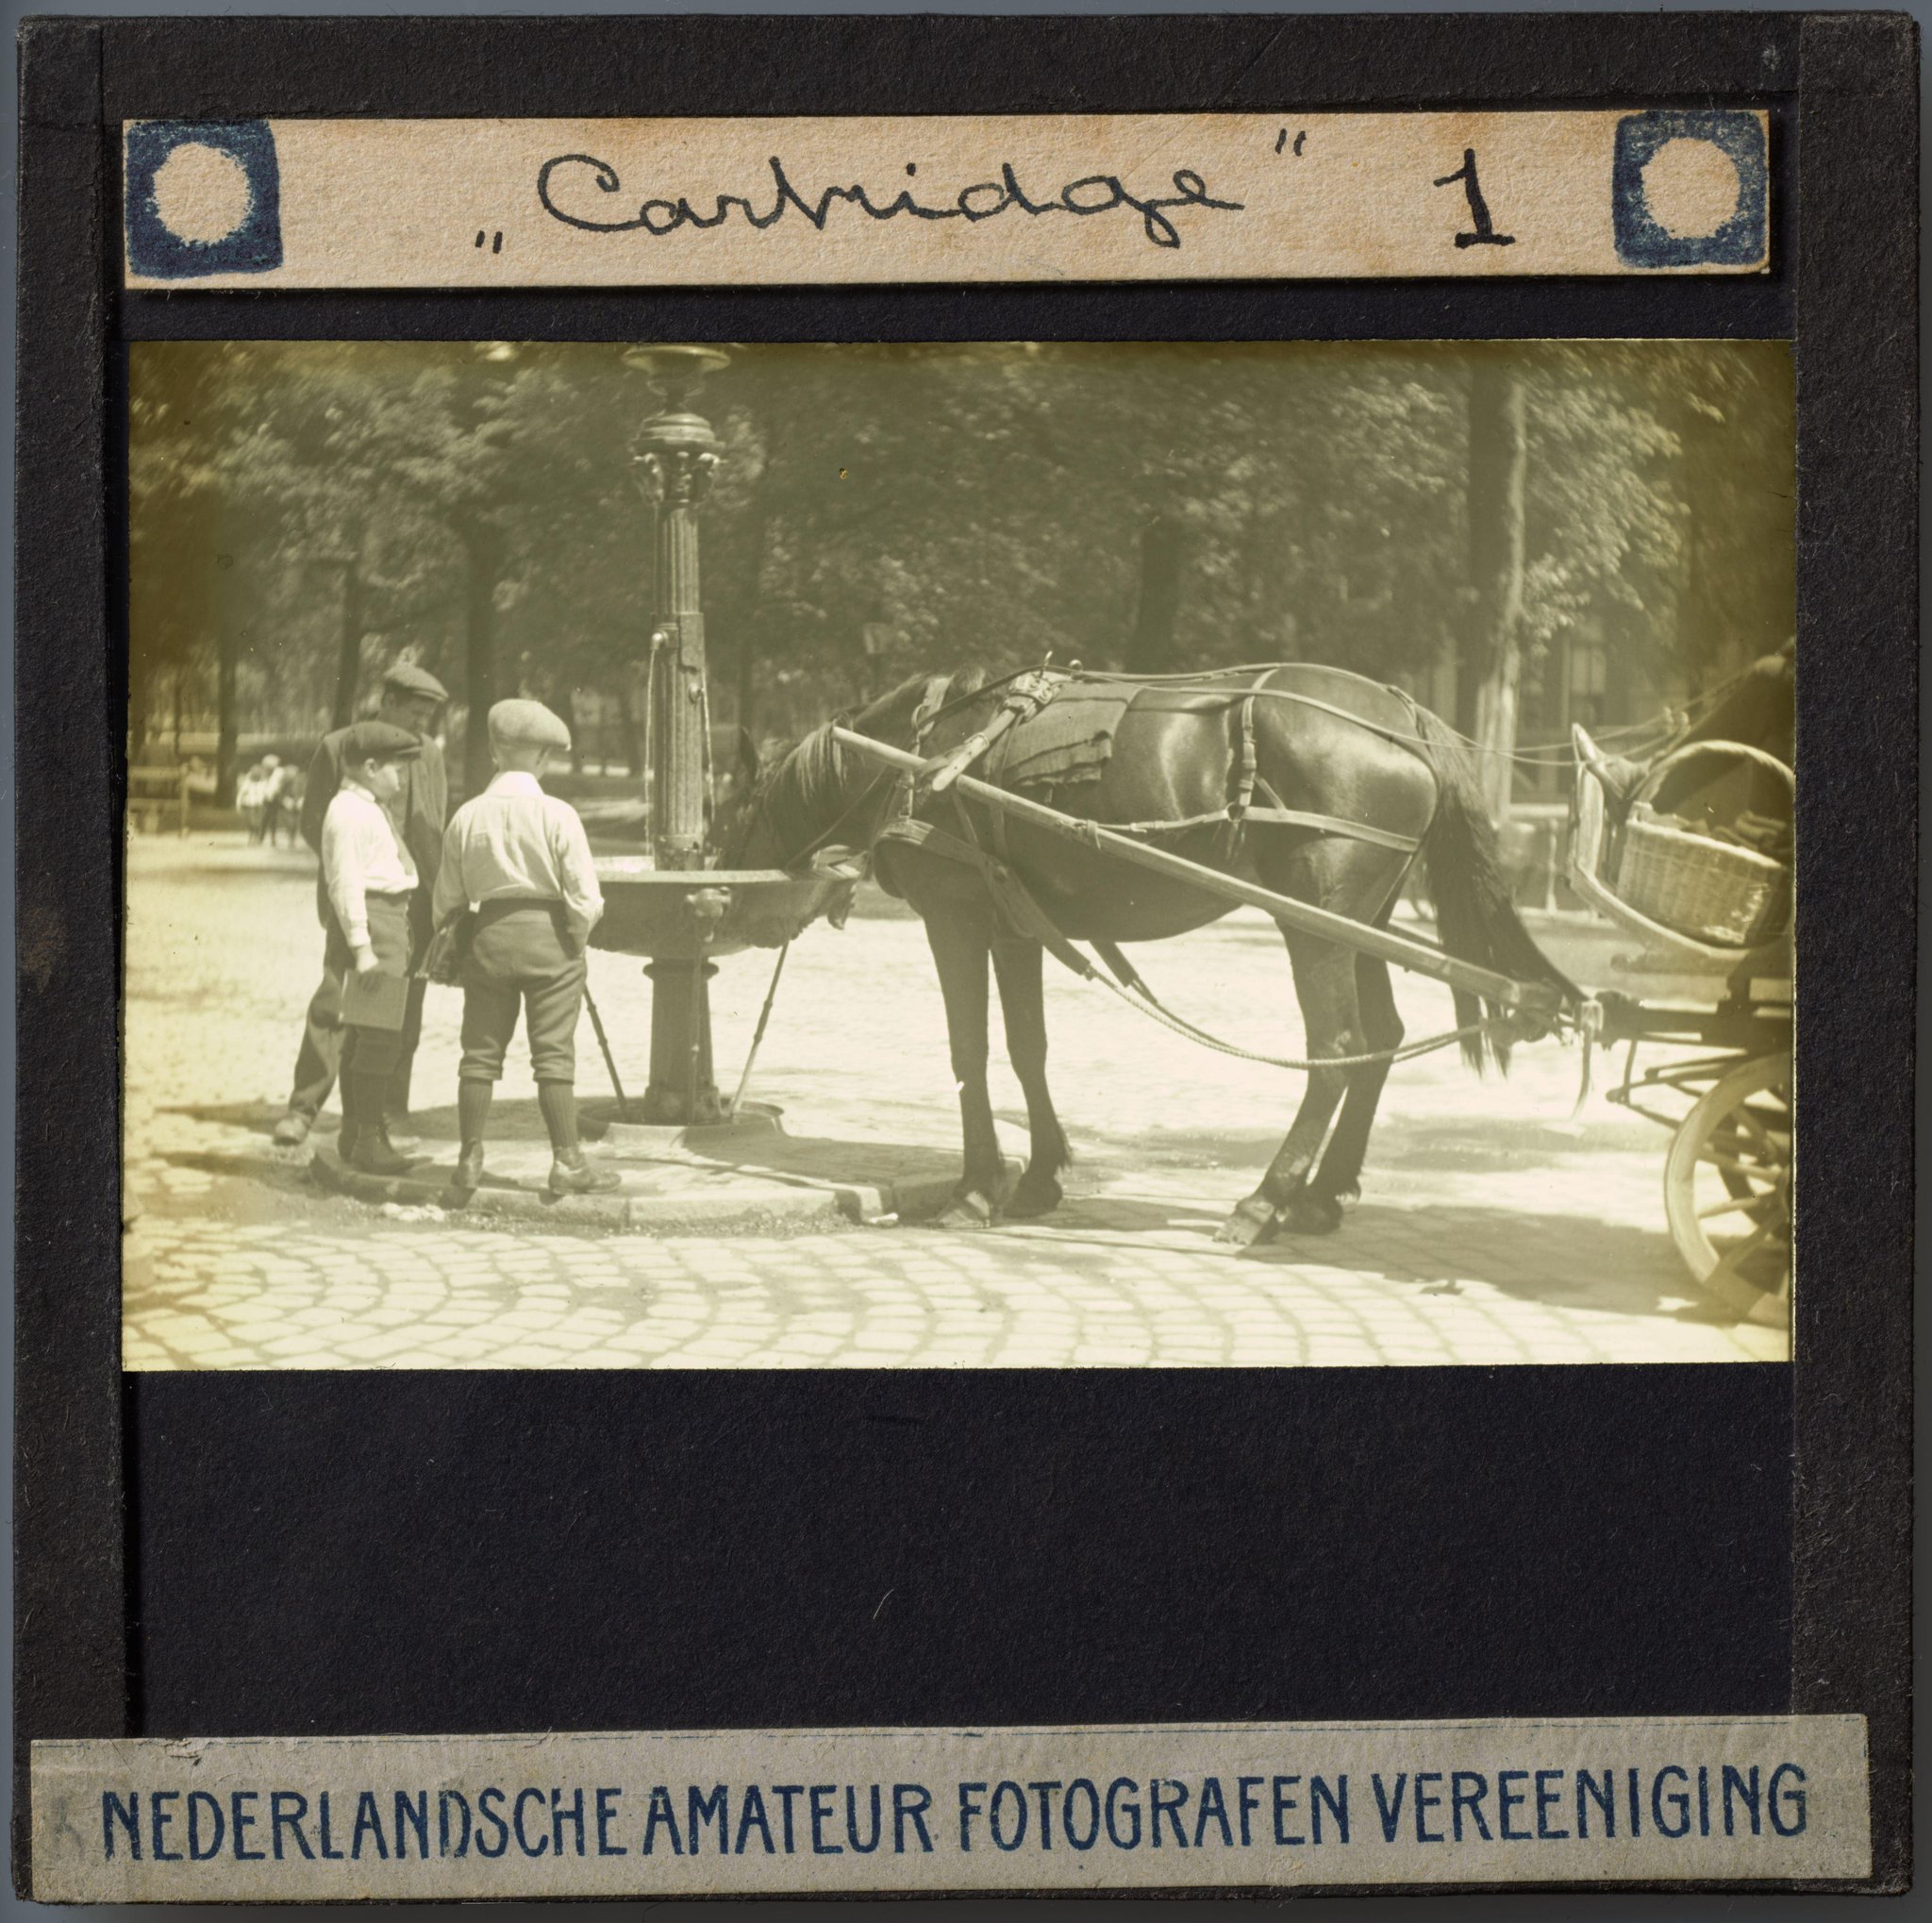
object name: lantern slide photographic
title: Jongens bij een drinkend paard genaamd Cartridge, mogelijk in Amsterdam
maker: Anonymous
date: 1908-1913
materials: glass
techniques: slide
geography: amsterdam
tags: horse, amsterdam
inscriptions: number: ‘1’, inscription: ‘NEDERLANDSCHE AMATEUR FOTOGRAFEN VEREENIGING’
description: Uit een serie lantaarnplaatjes afkomstig van amateurfotograaf G.J. Schuur en de Nederlandsche Amateur Fotografen Vereeniging.